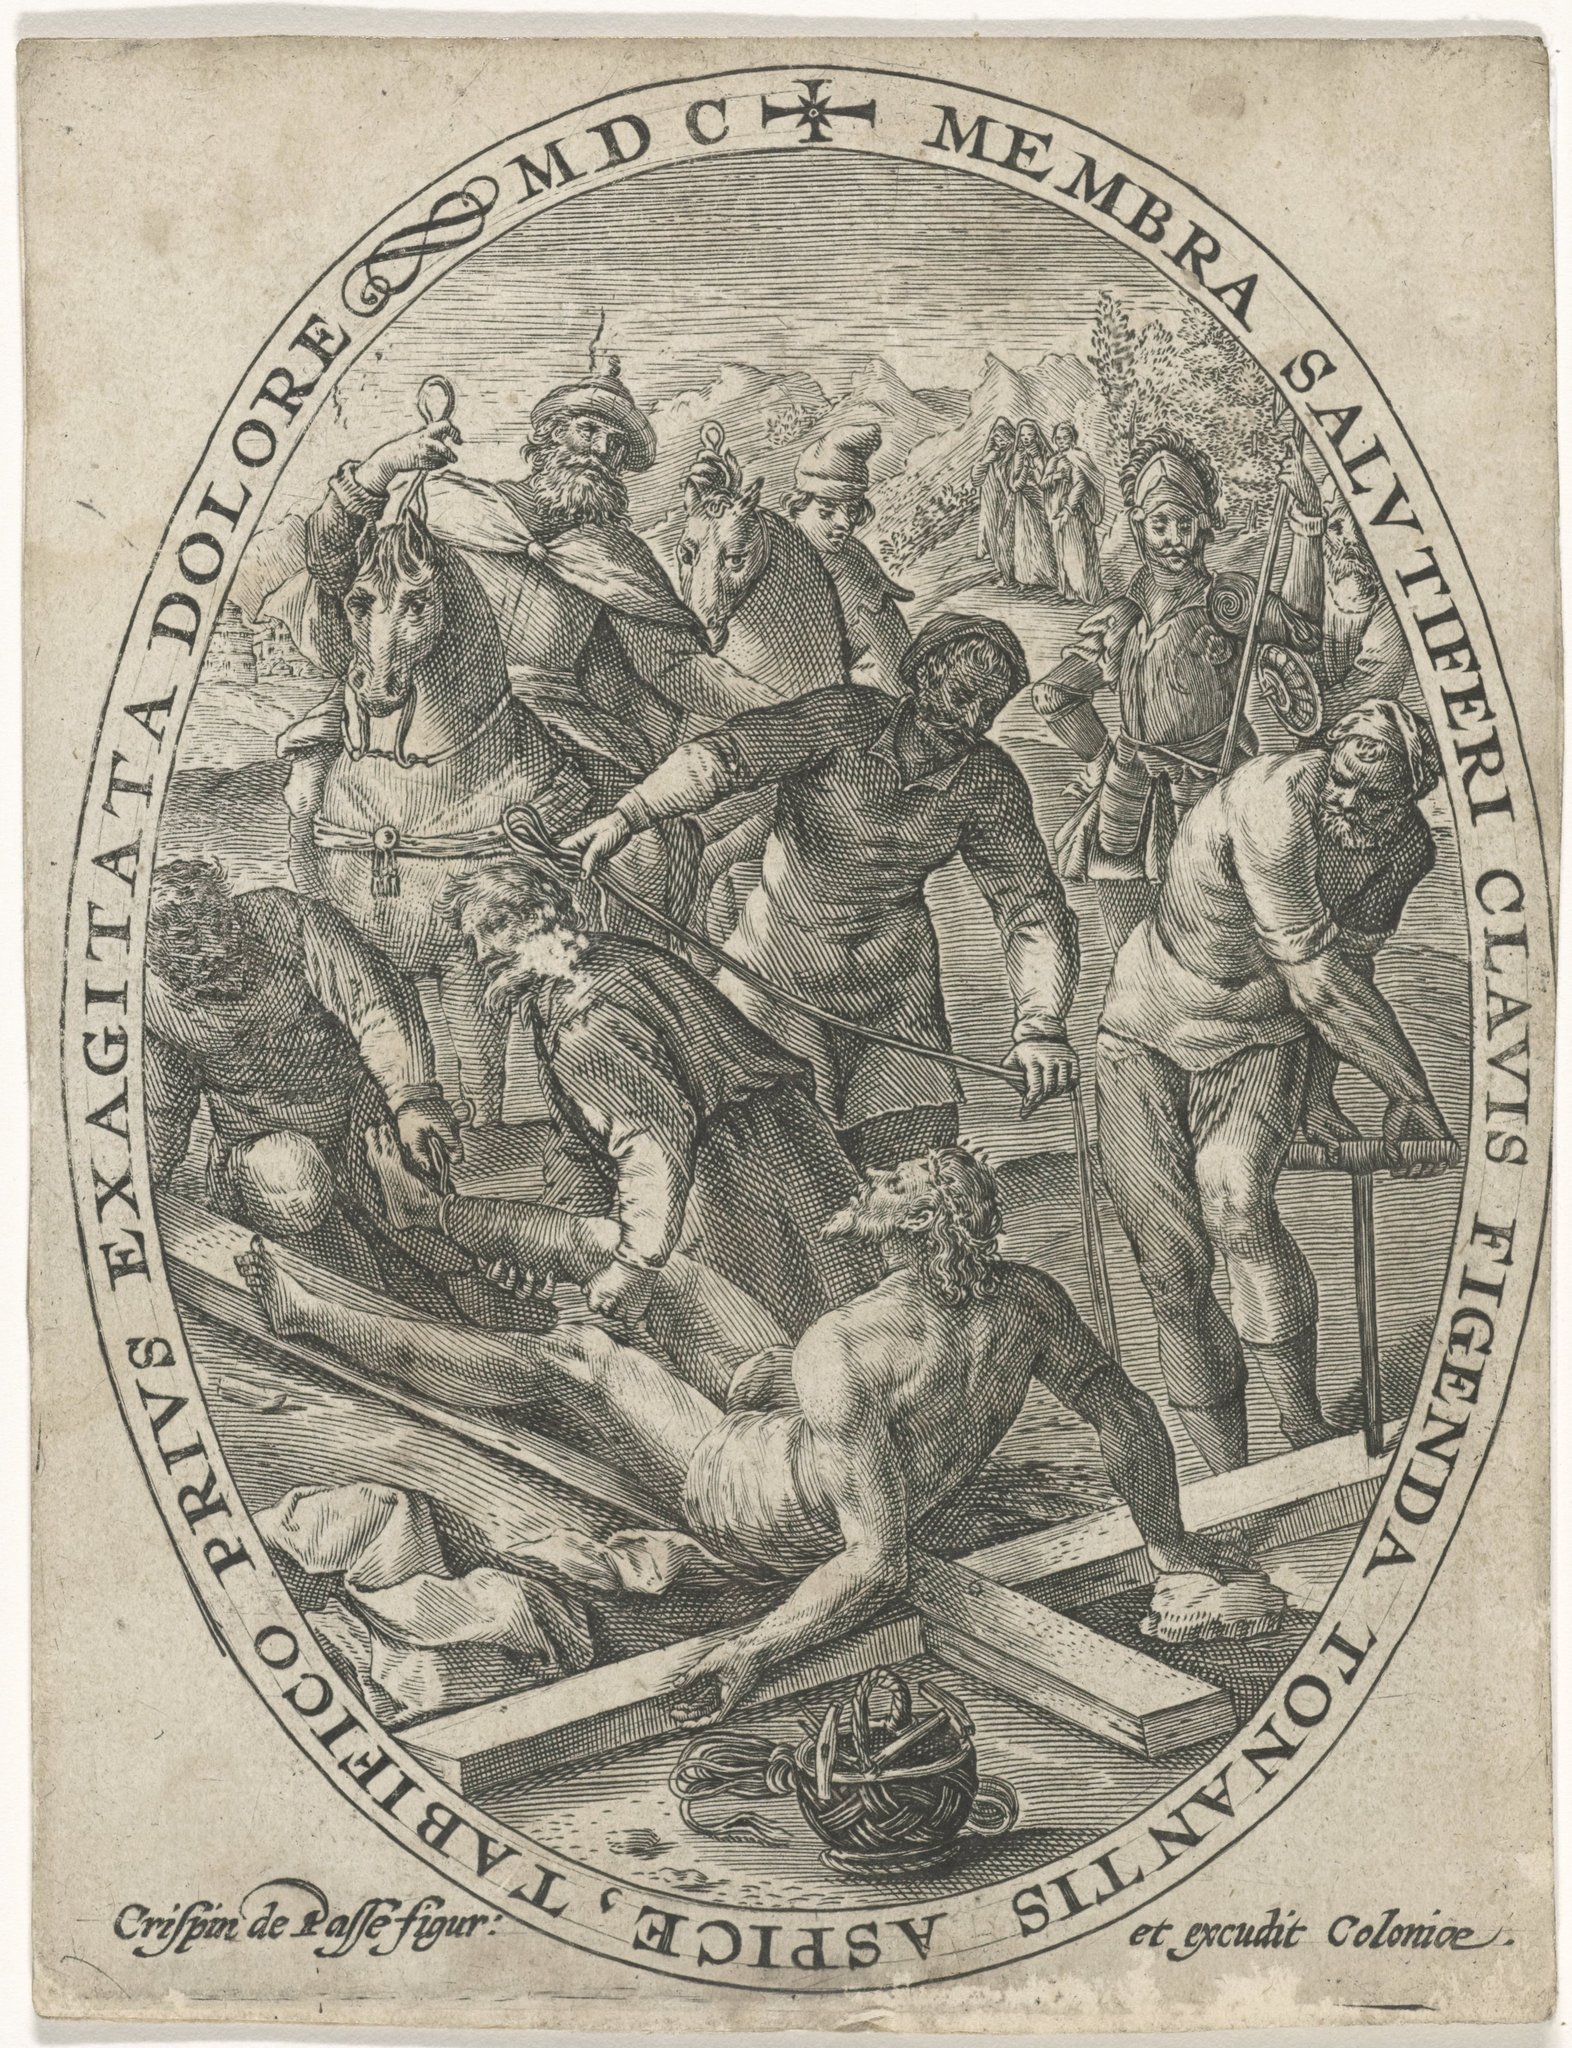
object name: print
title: Passie van Christus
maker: crispijn van de passe (i)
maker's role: draughtsman, print maker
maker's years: 1564-1637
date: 1600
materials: paper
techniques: engraving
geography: cologne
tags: the erection of the cross: christ is nailed to the cross which lies on the ground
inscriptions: collector's mark: Lugt 2228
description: Christus wordt aan het kruis genageld. Op de voorgrond een mand met touw, spijkers en een hamer. Op de achtergrond Maria, Maria Magdalena en Johannes de Doper. De voorstelling is gevat in een ovale omlijsting met een randschrift in het Latijn. Prent uit een serie met de passie van Christus.